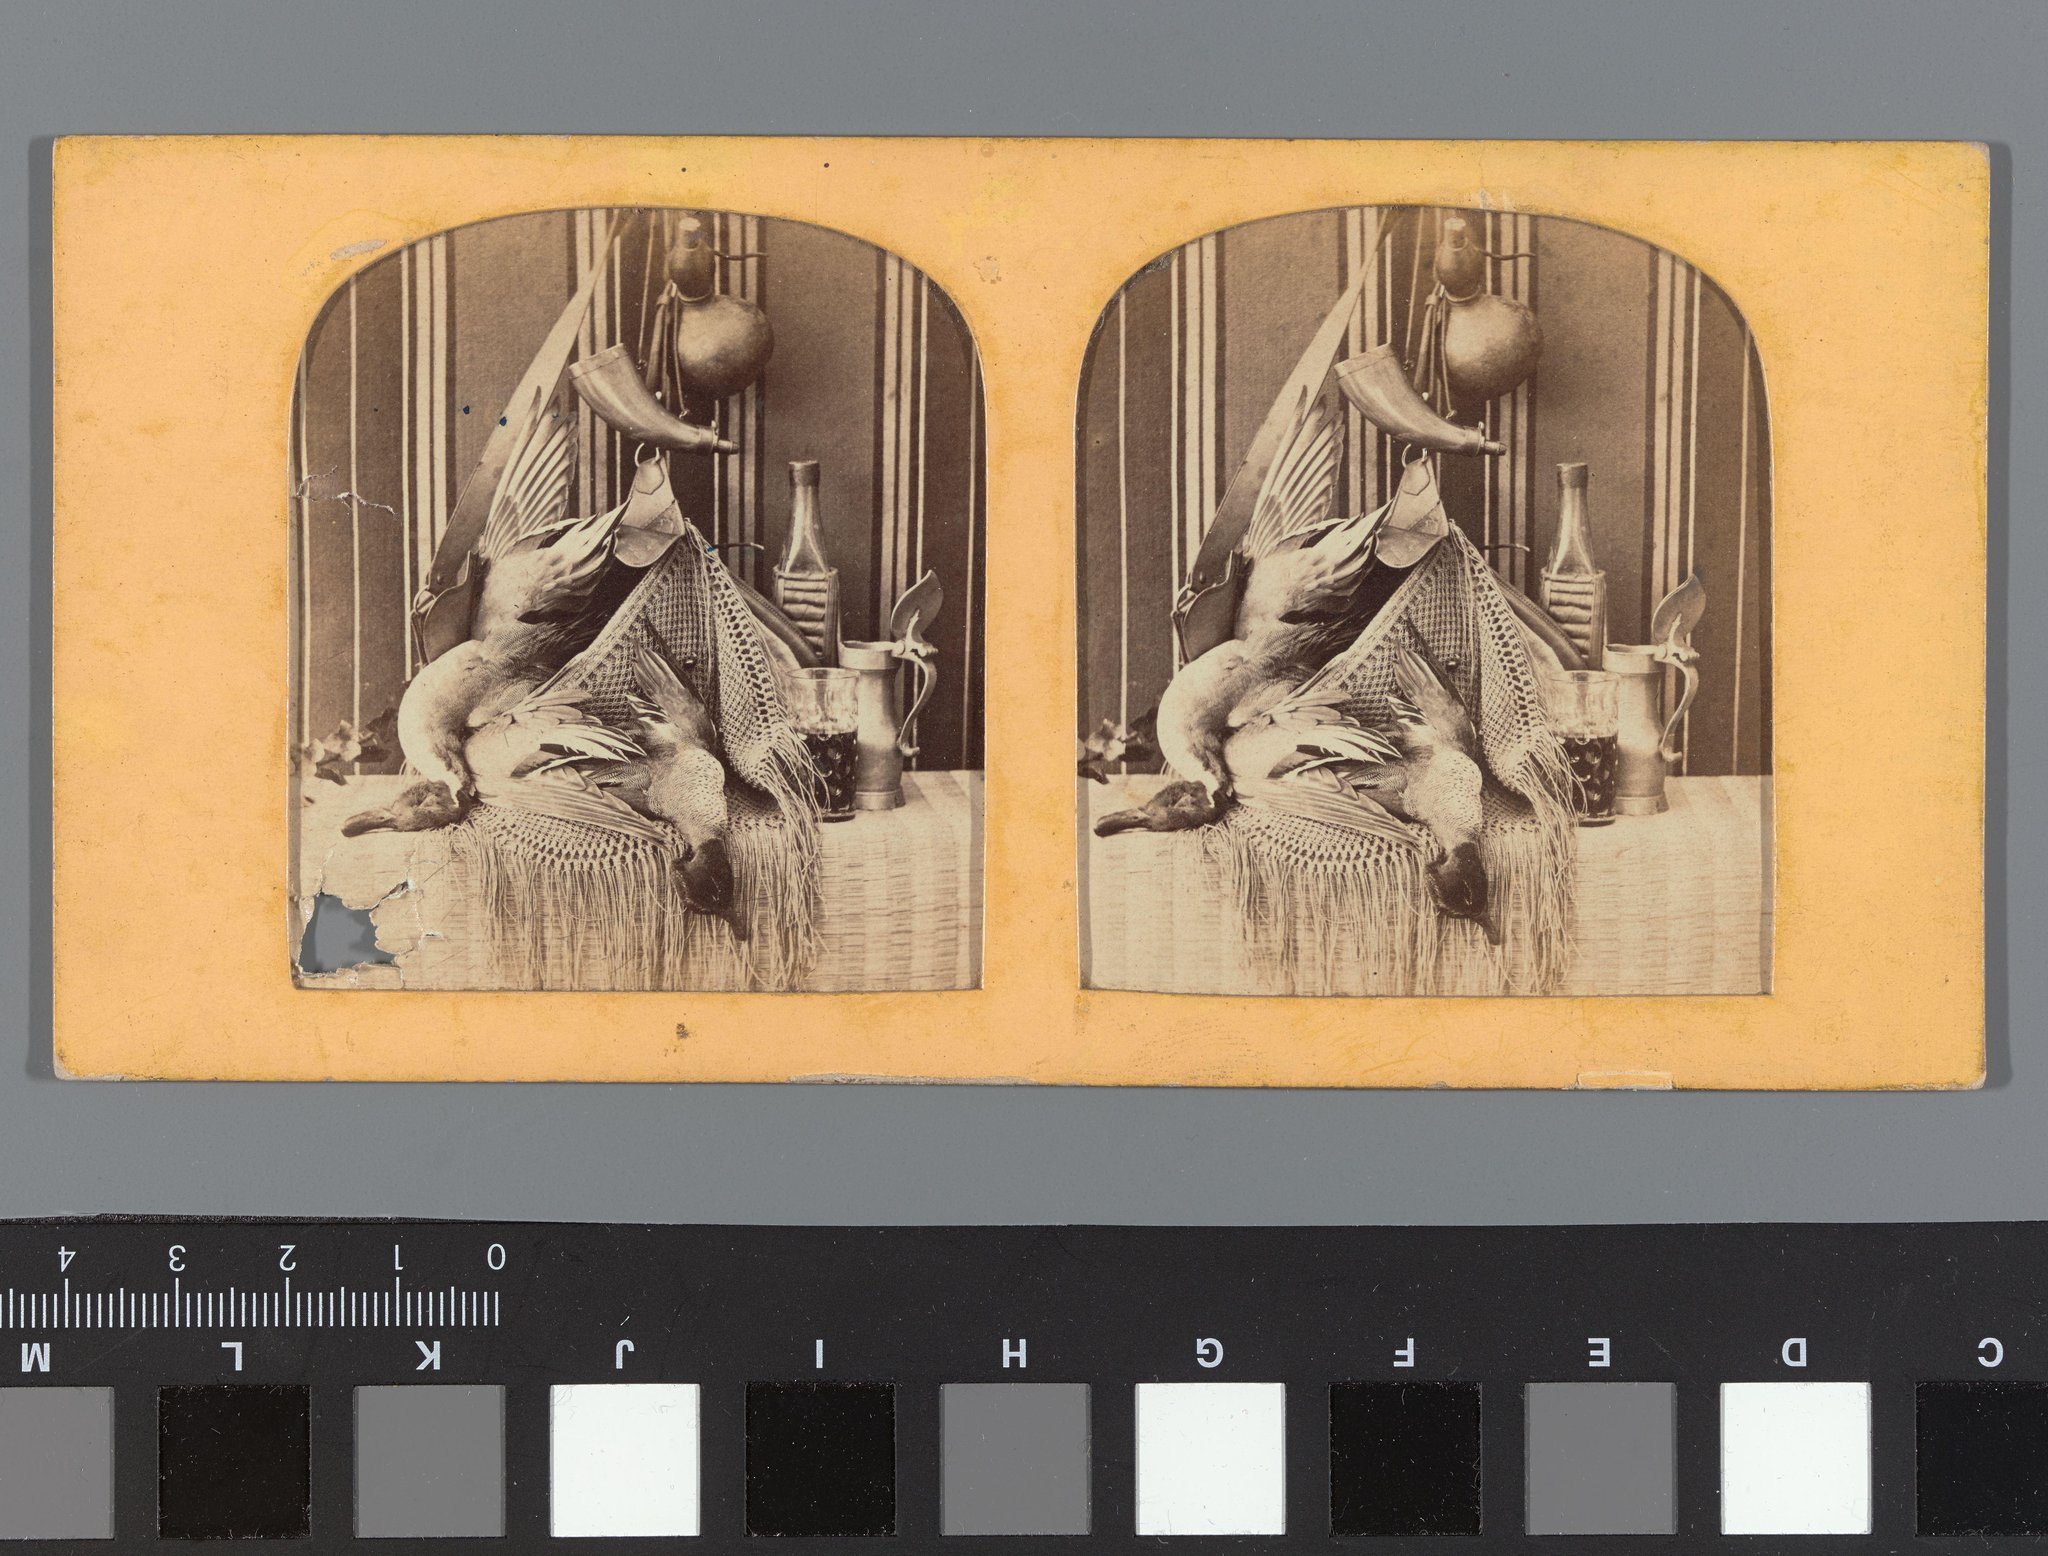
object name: tissue stereograph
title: Stilleven met gevogelte, kruiken en jachtattributen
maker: Anonymous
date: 1860-1890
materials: cardboard, paper, photographic support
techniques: albumen print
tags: birds, bird hunting, still life of miscellaneous objects